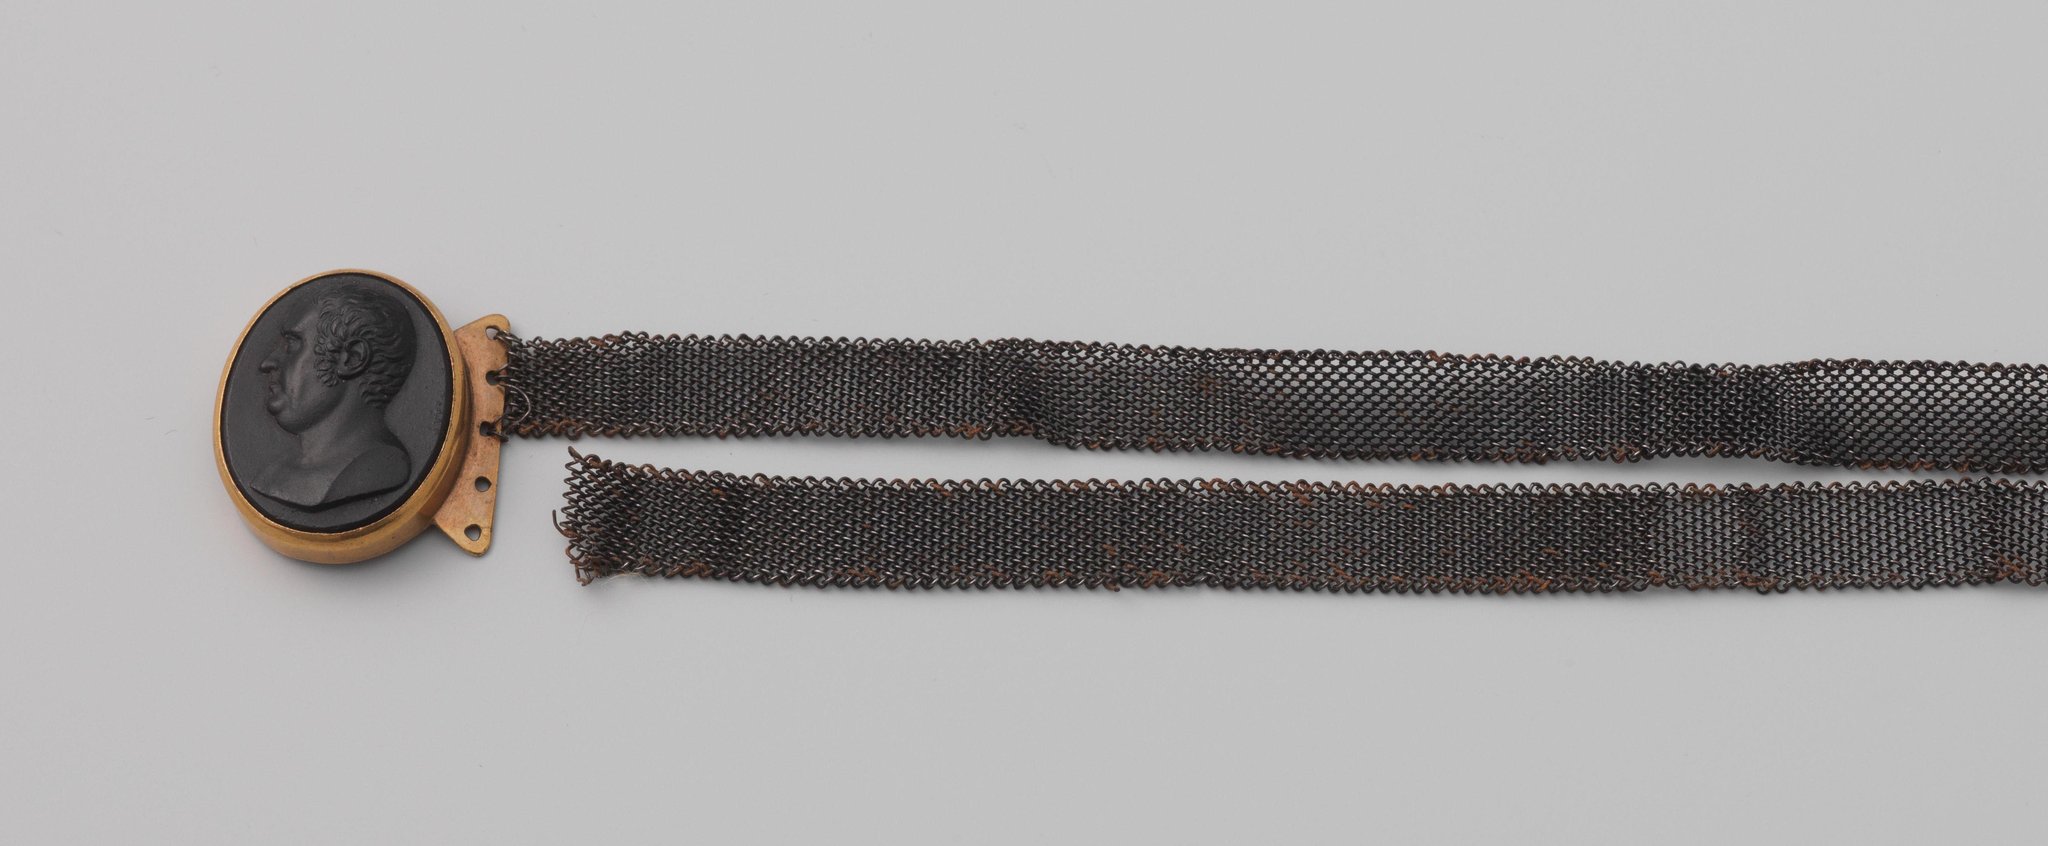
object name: bracelet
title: Armband van ijzer met camee in gouden slot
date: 1815-1830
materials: gold, iron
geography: great britain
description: Armband van zwart geverfd ijzer met een zwarte camee in een gouden slot. Aan het ovale slot zijn twee banden bevestigd die nauw om de pols sluiten en van extreem fijne, in elkaar grijpende maliën zijn gemaakt. Op de camee een kop van een dikke, oude man met kort haar.